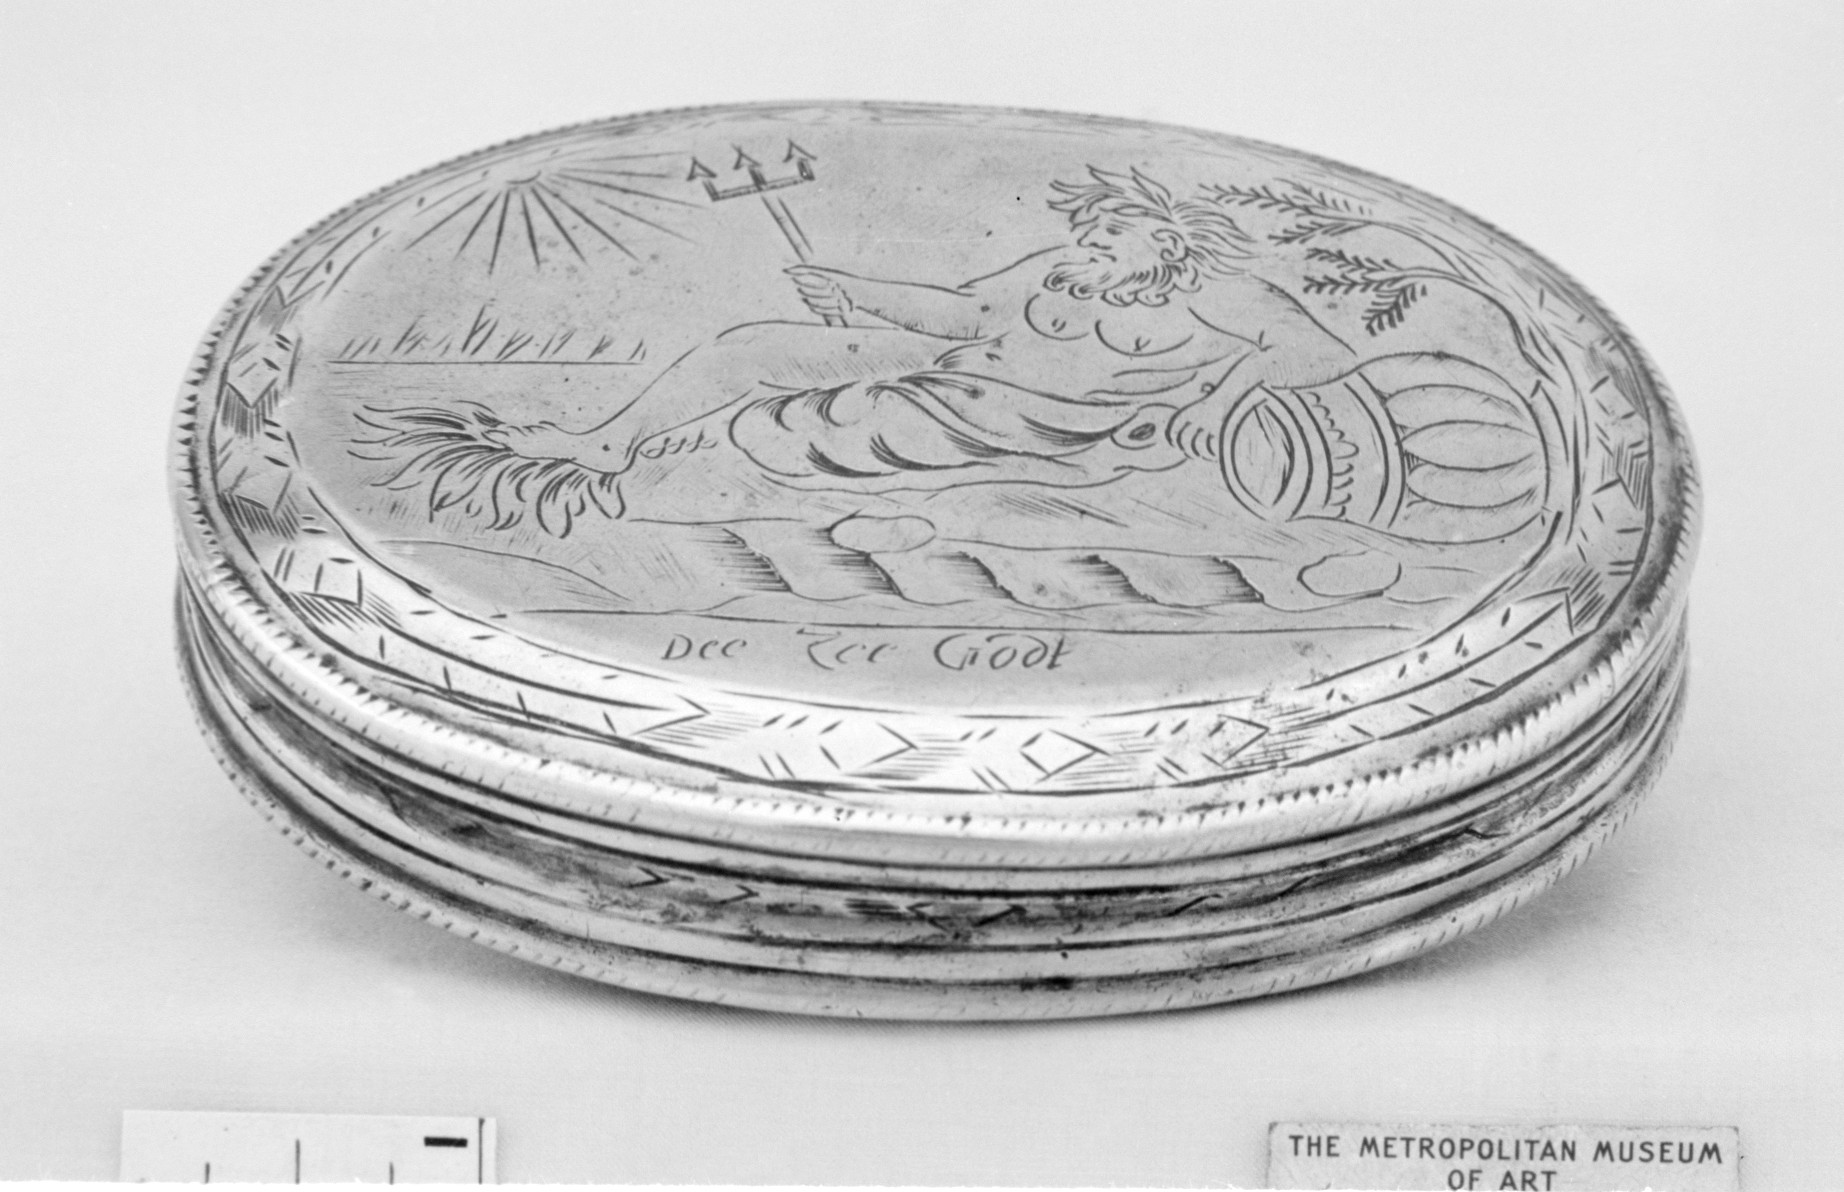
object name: tobacco box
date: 1701-1800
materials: brass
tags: neptune